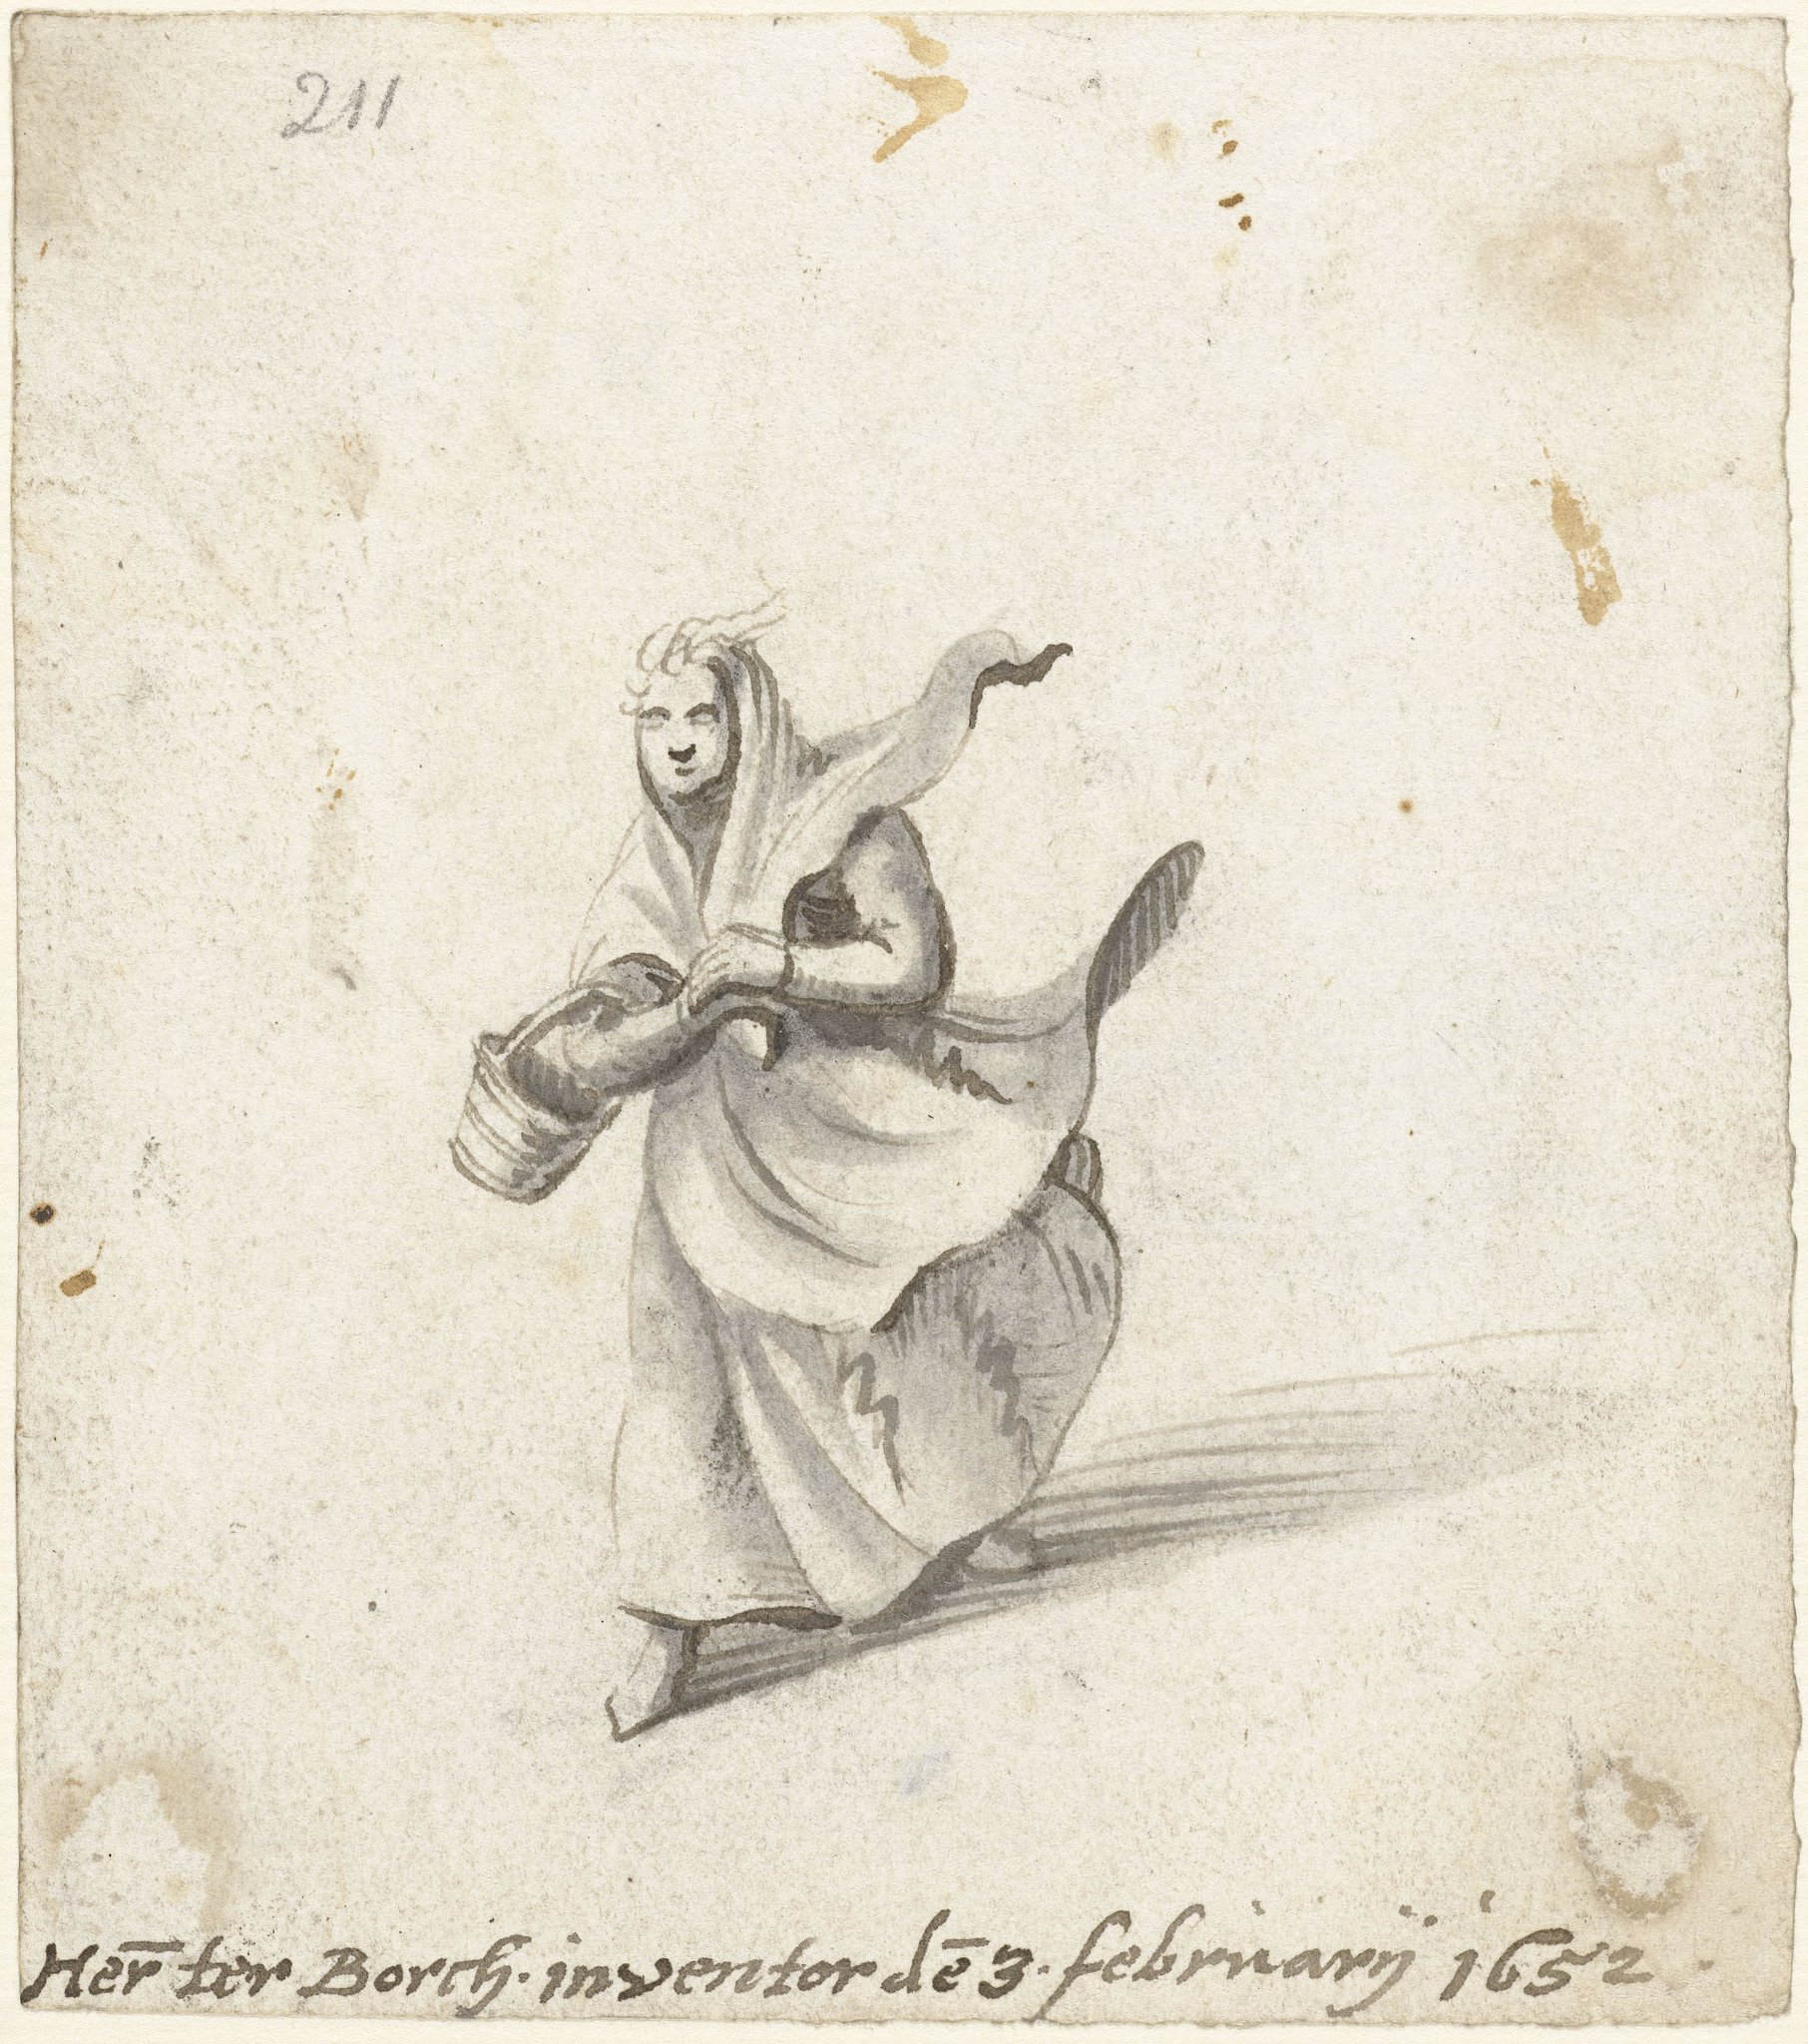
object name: drawing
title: Vrouw met een sjaal en een schort om, driekwart naar links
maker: harmen ter borch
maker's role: draughtsman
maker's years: 1638-1677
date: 1652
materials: ink, paper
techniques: brush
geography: zwolle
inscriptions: annotation: ‘Her[man] ter Borch. inventor de[n] 3.februarij 1652’